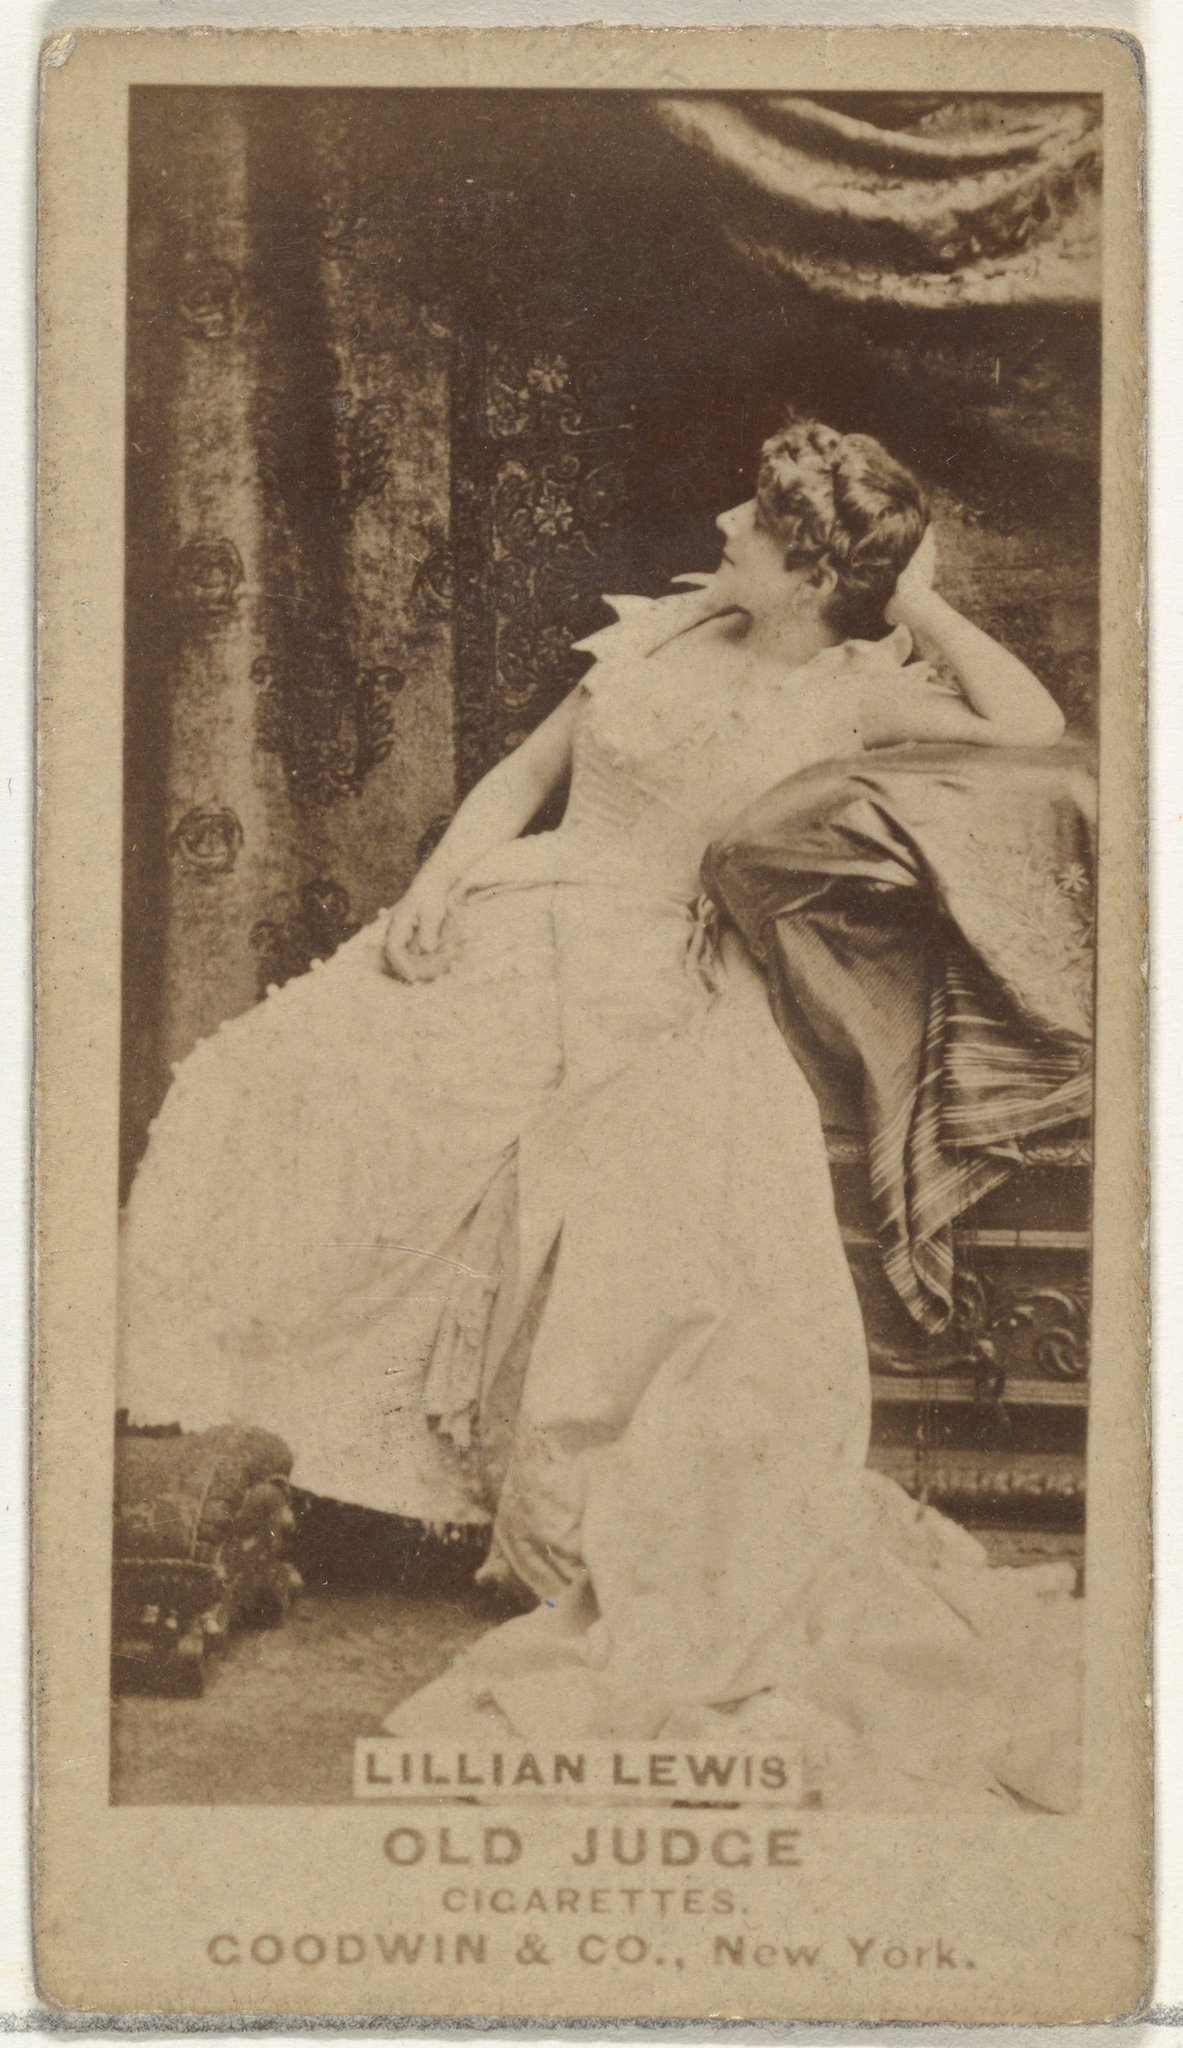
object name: photograph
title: Lillian Lewis, from the Actors and Actresses series (N171) for Old Judge Cigarettes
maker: goodwin & company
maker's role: publisher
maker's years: 1850-1950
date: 1886-1890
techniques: albumen silver print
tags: portraits,women,actresses